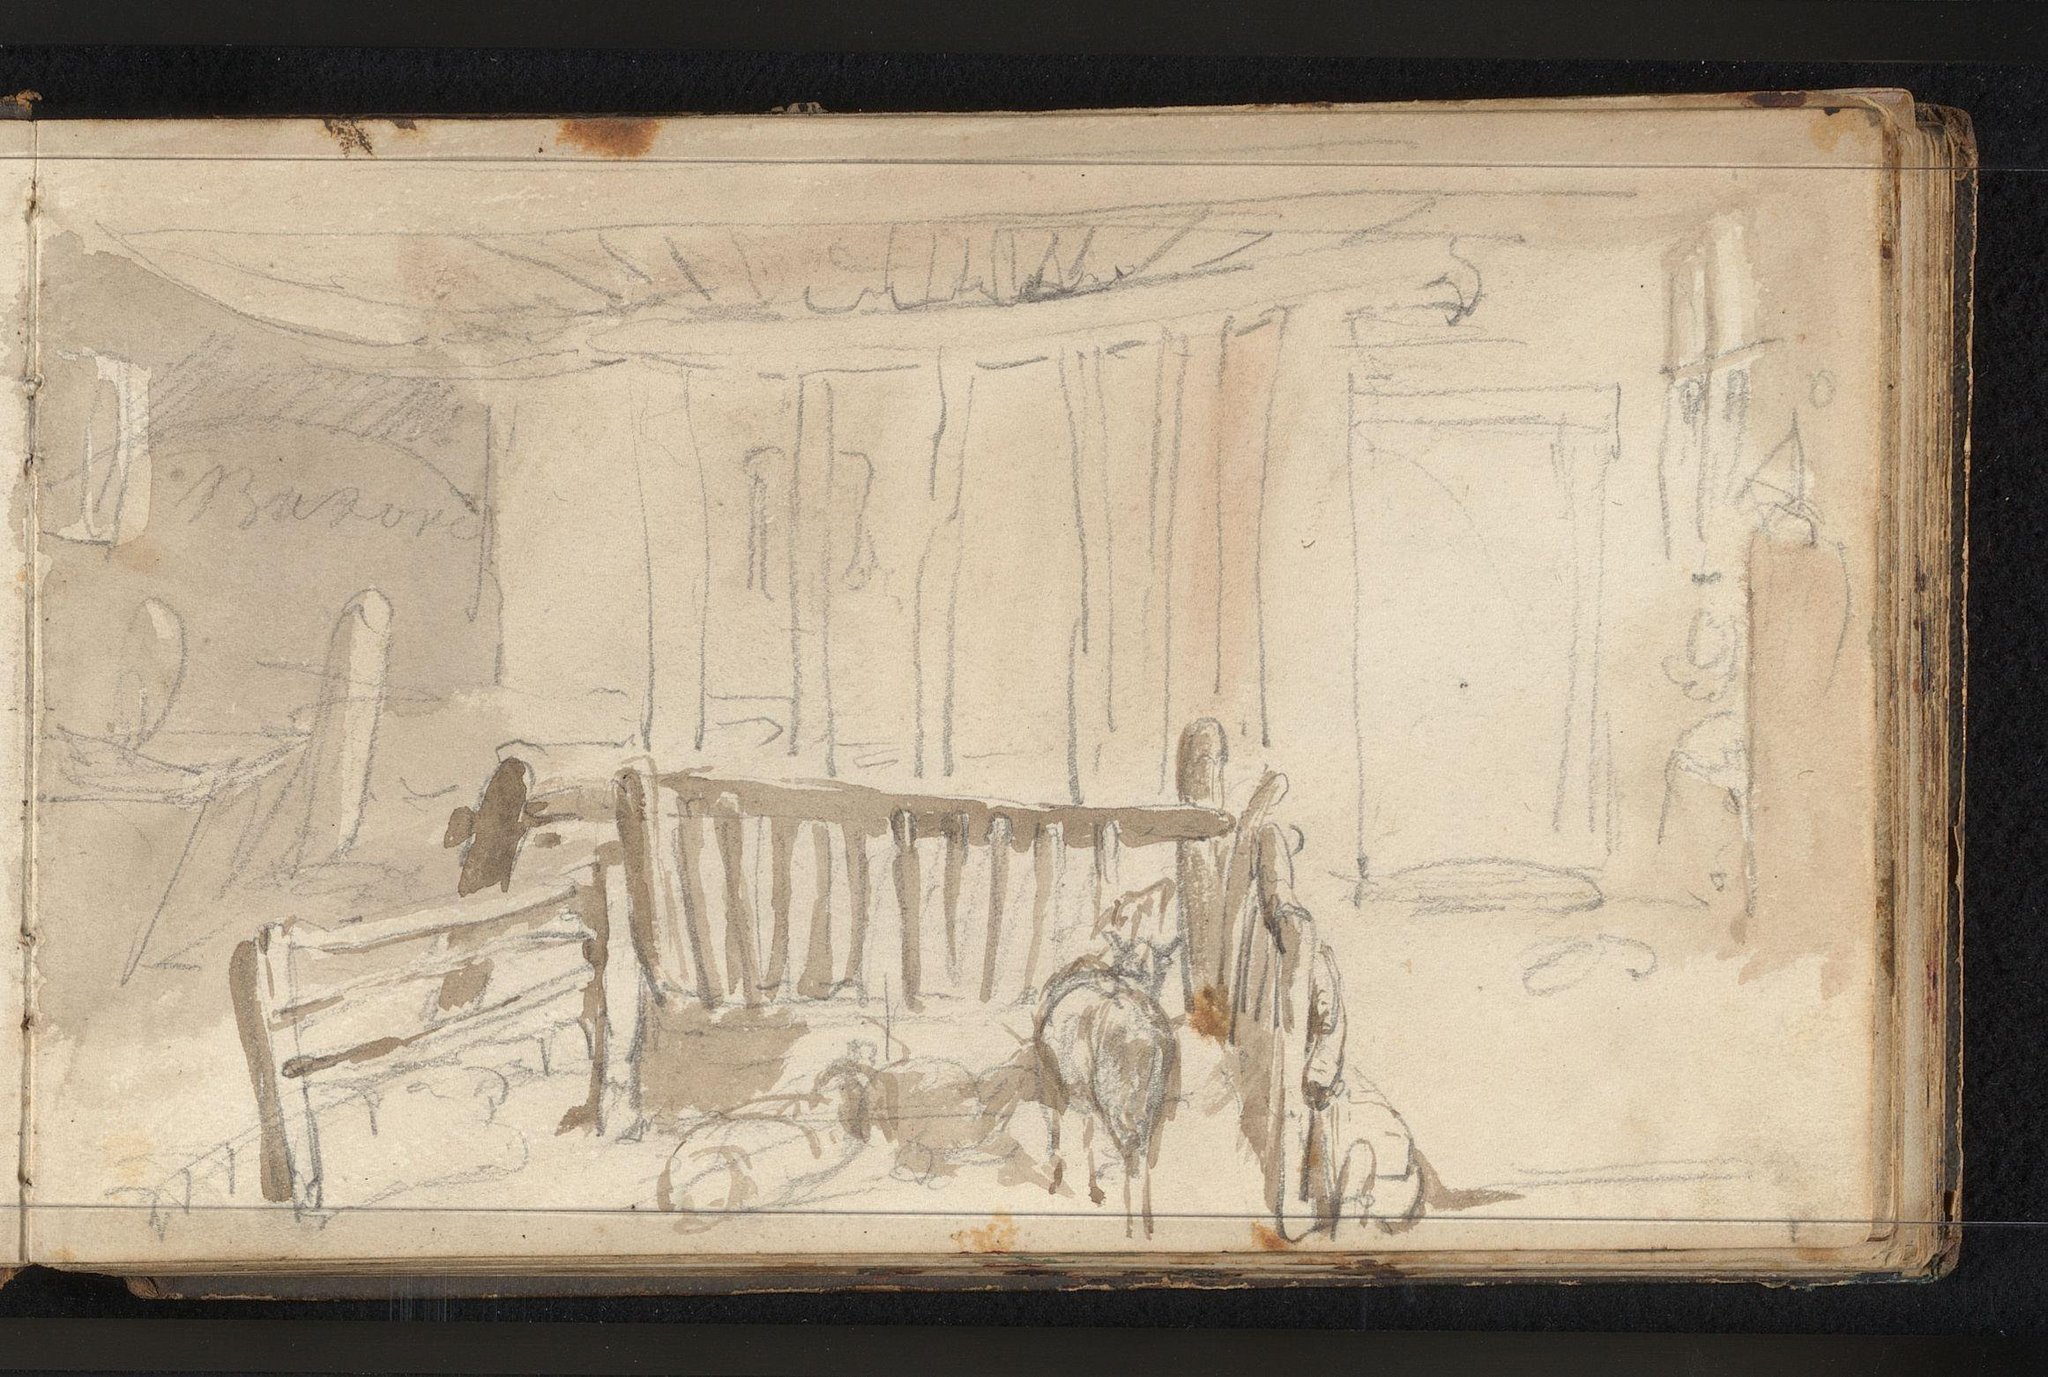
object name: sketchbook leaf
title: Binnenkant van een stal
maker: jan bedijs tom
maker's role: draughtsman, painter, print maker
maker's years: 1813-1894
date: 1828-1894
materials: paper, pencil, watercolor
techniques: brush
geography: the hague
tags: barn, artist (in general) making preliminary designs, sketching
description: Pagina 47 verso uit een schetsboek met 54 bladen.